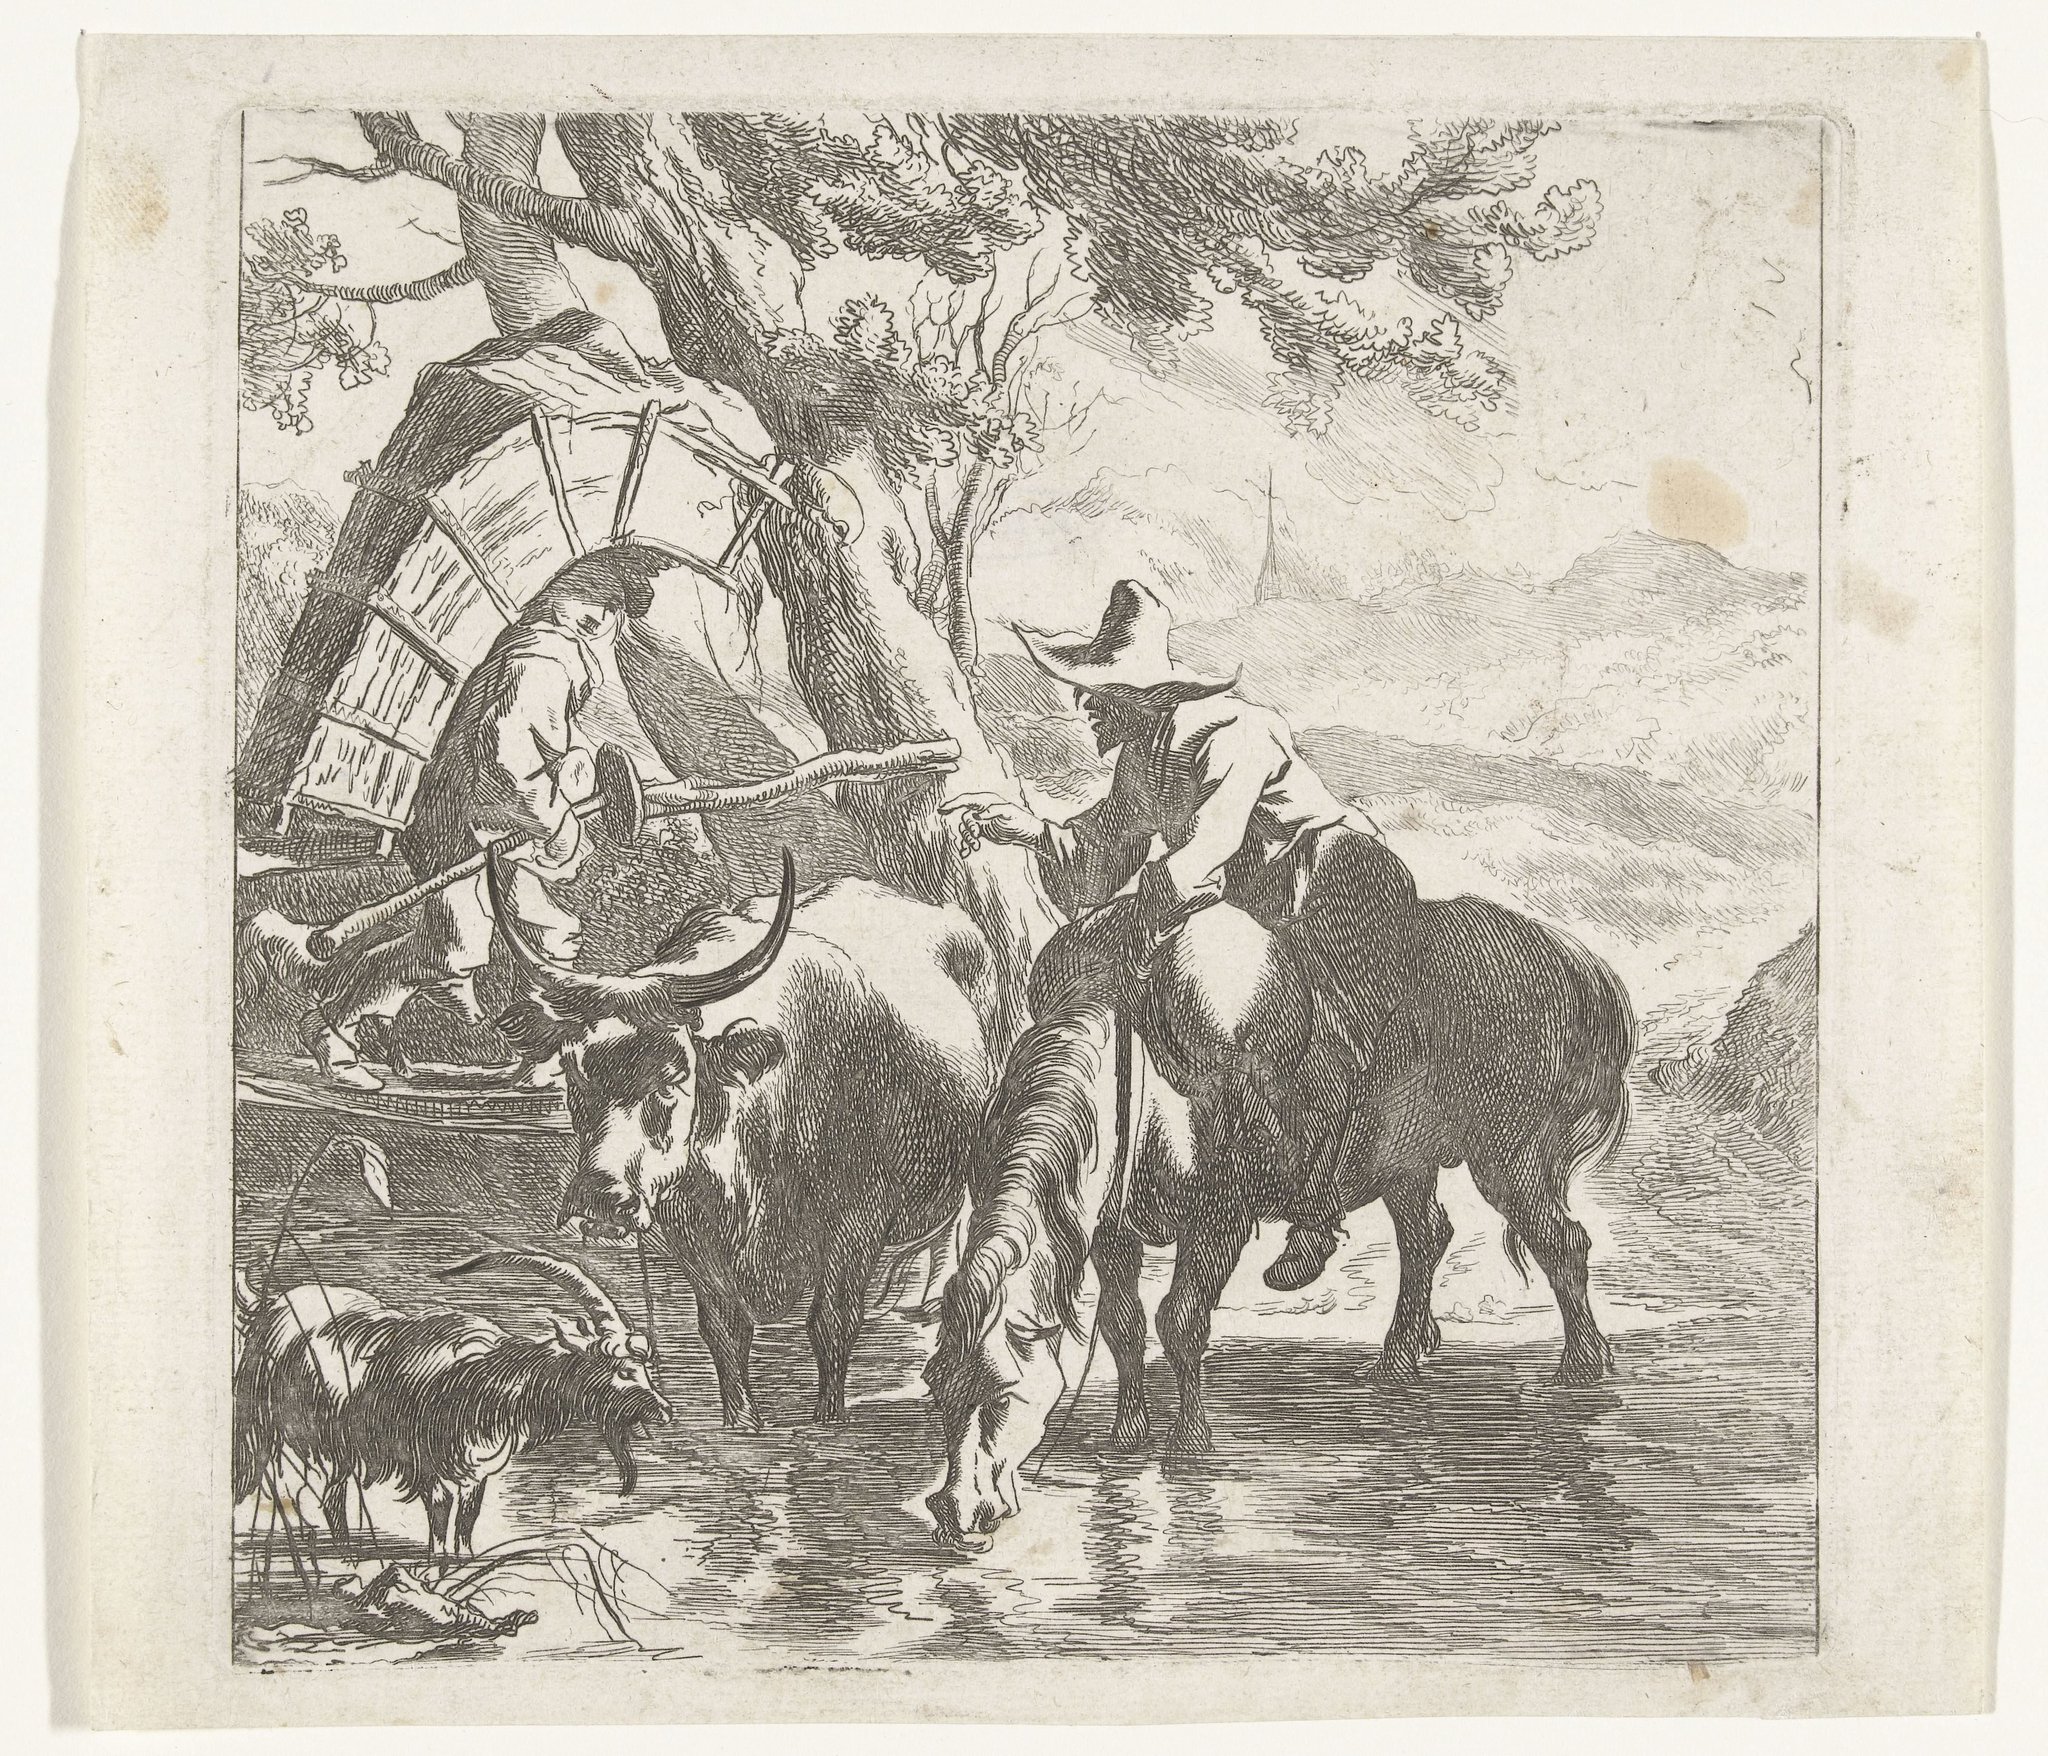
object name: print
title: Jongen op een houten brug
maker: Anonymous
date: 1646-1742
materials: paper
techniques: etching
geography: netherlands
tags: riding a horse, ass, or mule; rider, horseman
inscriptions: collector's mark: Lugt 2228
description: Een jongen loopt op een houten brug met een staf in zijn hand. Hij praat met een man op een paard. Het paard staat in het water. Naast het paard staan een os en een geit.